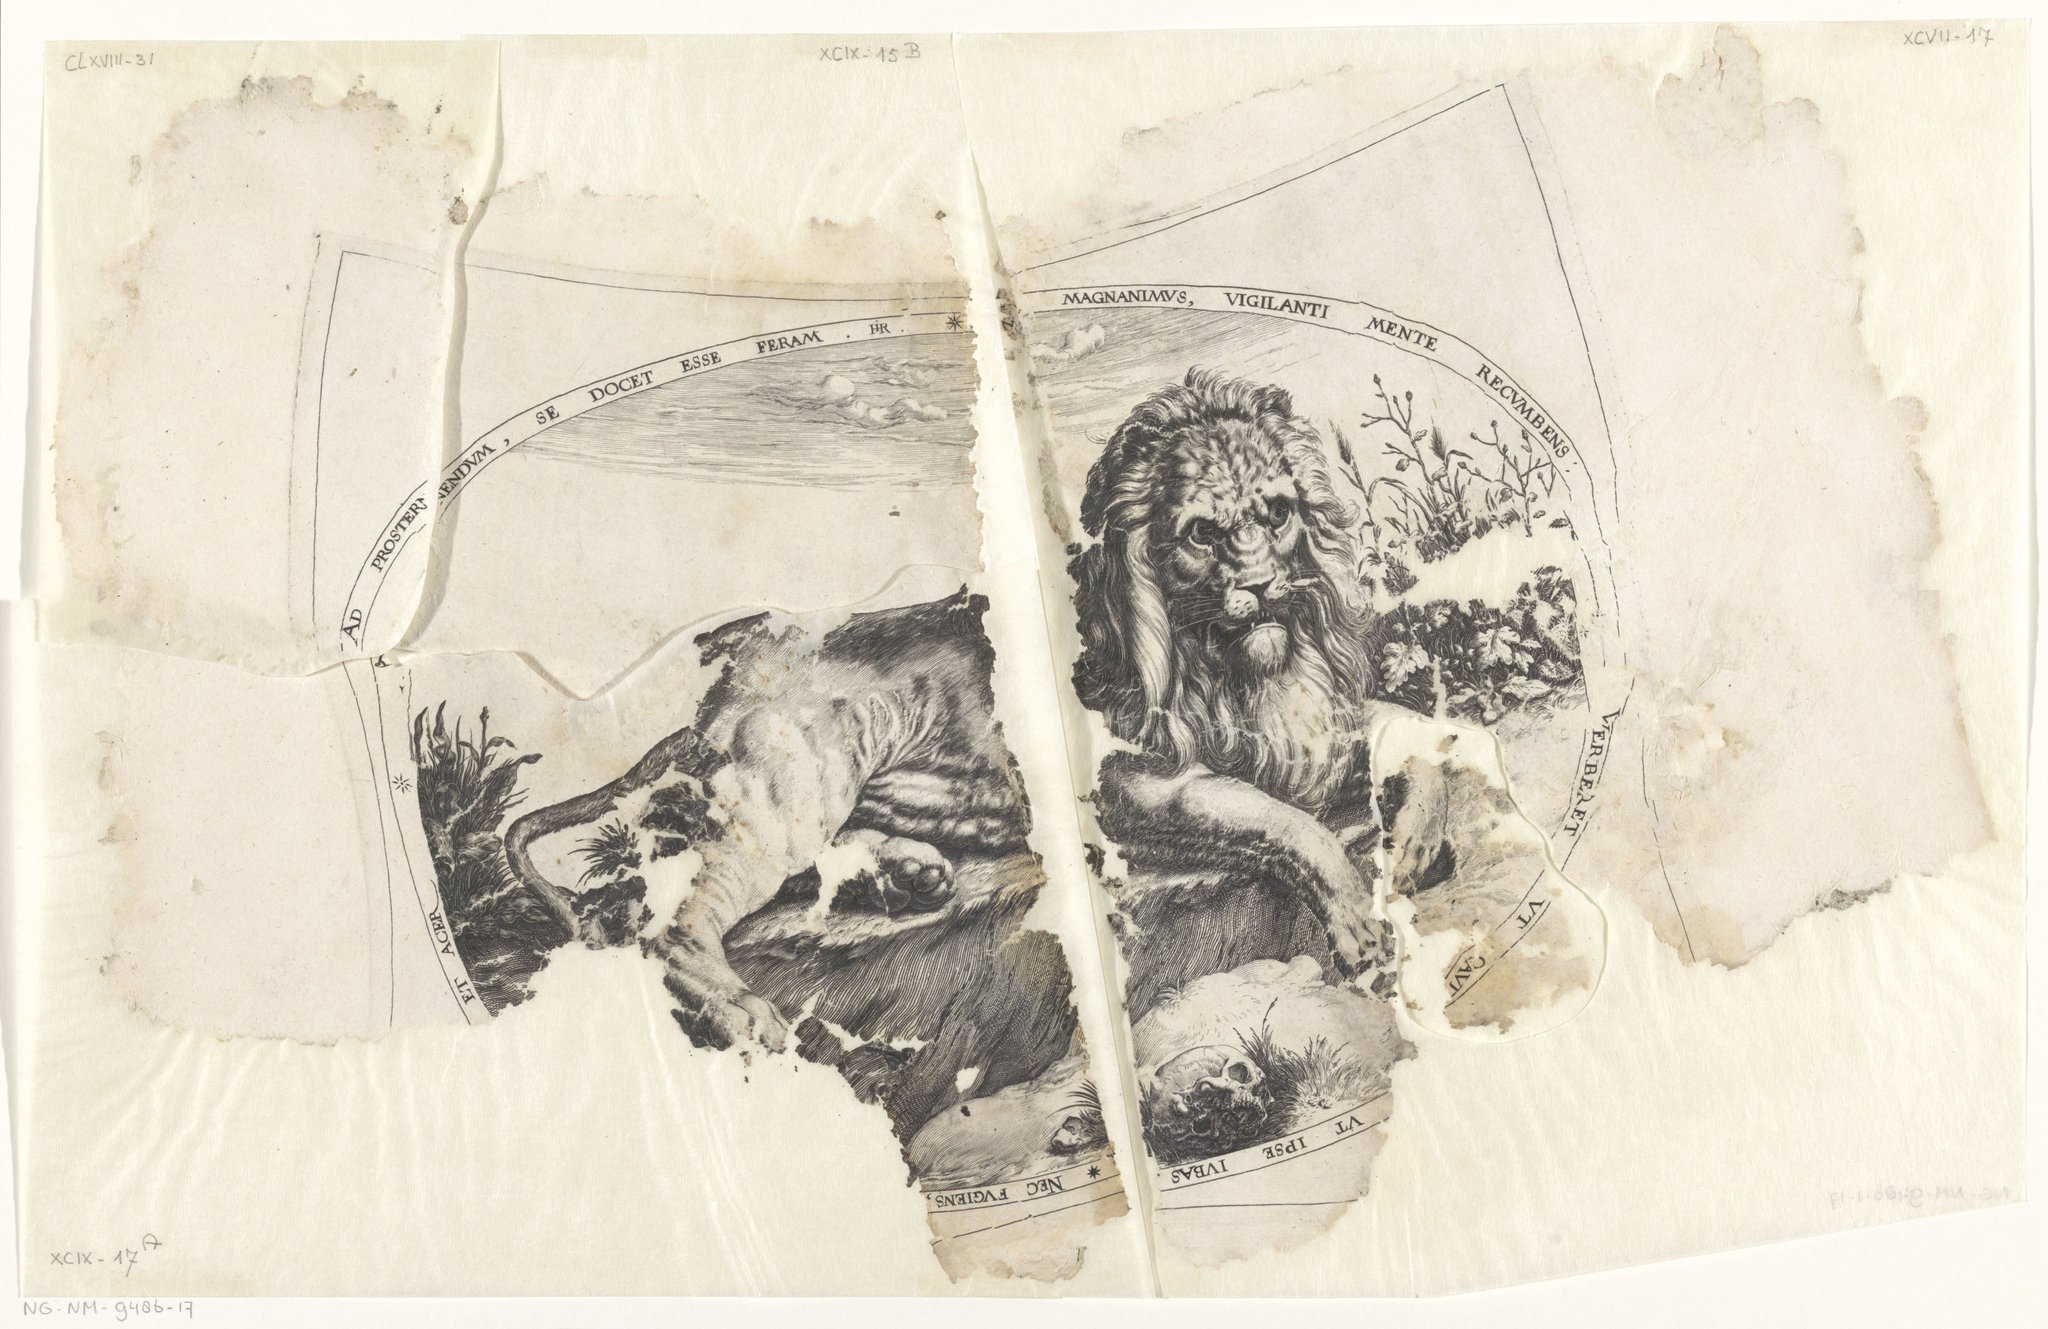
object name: print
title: Leeuw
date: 1580-1596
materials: paper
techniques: engraving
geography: northern netherlands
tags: beasts of prey, predatory animals: lion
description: De prenten in de Nova Zembla collectie zijn tijdens een expeditie van Willem Barendsz en Jacob van Heemskerk in 1596-1597 noodgedwongen in het winterkamp, het ‘Behouden Huis’, op het eiland achtergelaten. De prenten waren in één of meerdere stapels als handelswaar meegenomen vanuit Amsterdam. Bijna drie eeuwen later, in 1871, keerde de Noor Elling Carlsen terug naar Nova Zembla en vond daar de restanten van het ‘Behouden Huis, inclusief een groot deel van de inventaris. Een deel van de prenten, in de vorm van aaneengekoekte kluiten, werd toen ook teruggevonden. De papierkluiten waren soms op meerdere plekken gebroken. Tussen 1975-1979 zijn de prenten van elkaar gescheiden. Dit leverde in totaal ca. 1000 fragmenten van ca. 400 afdrukken van ca. 150 verschillende prenten op. Voor zover mogelijk zijn de fragmenten samengevoegd en zijn de prenten gereconstrueerd.